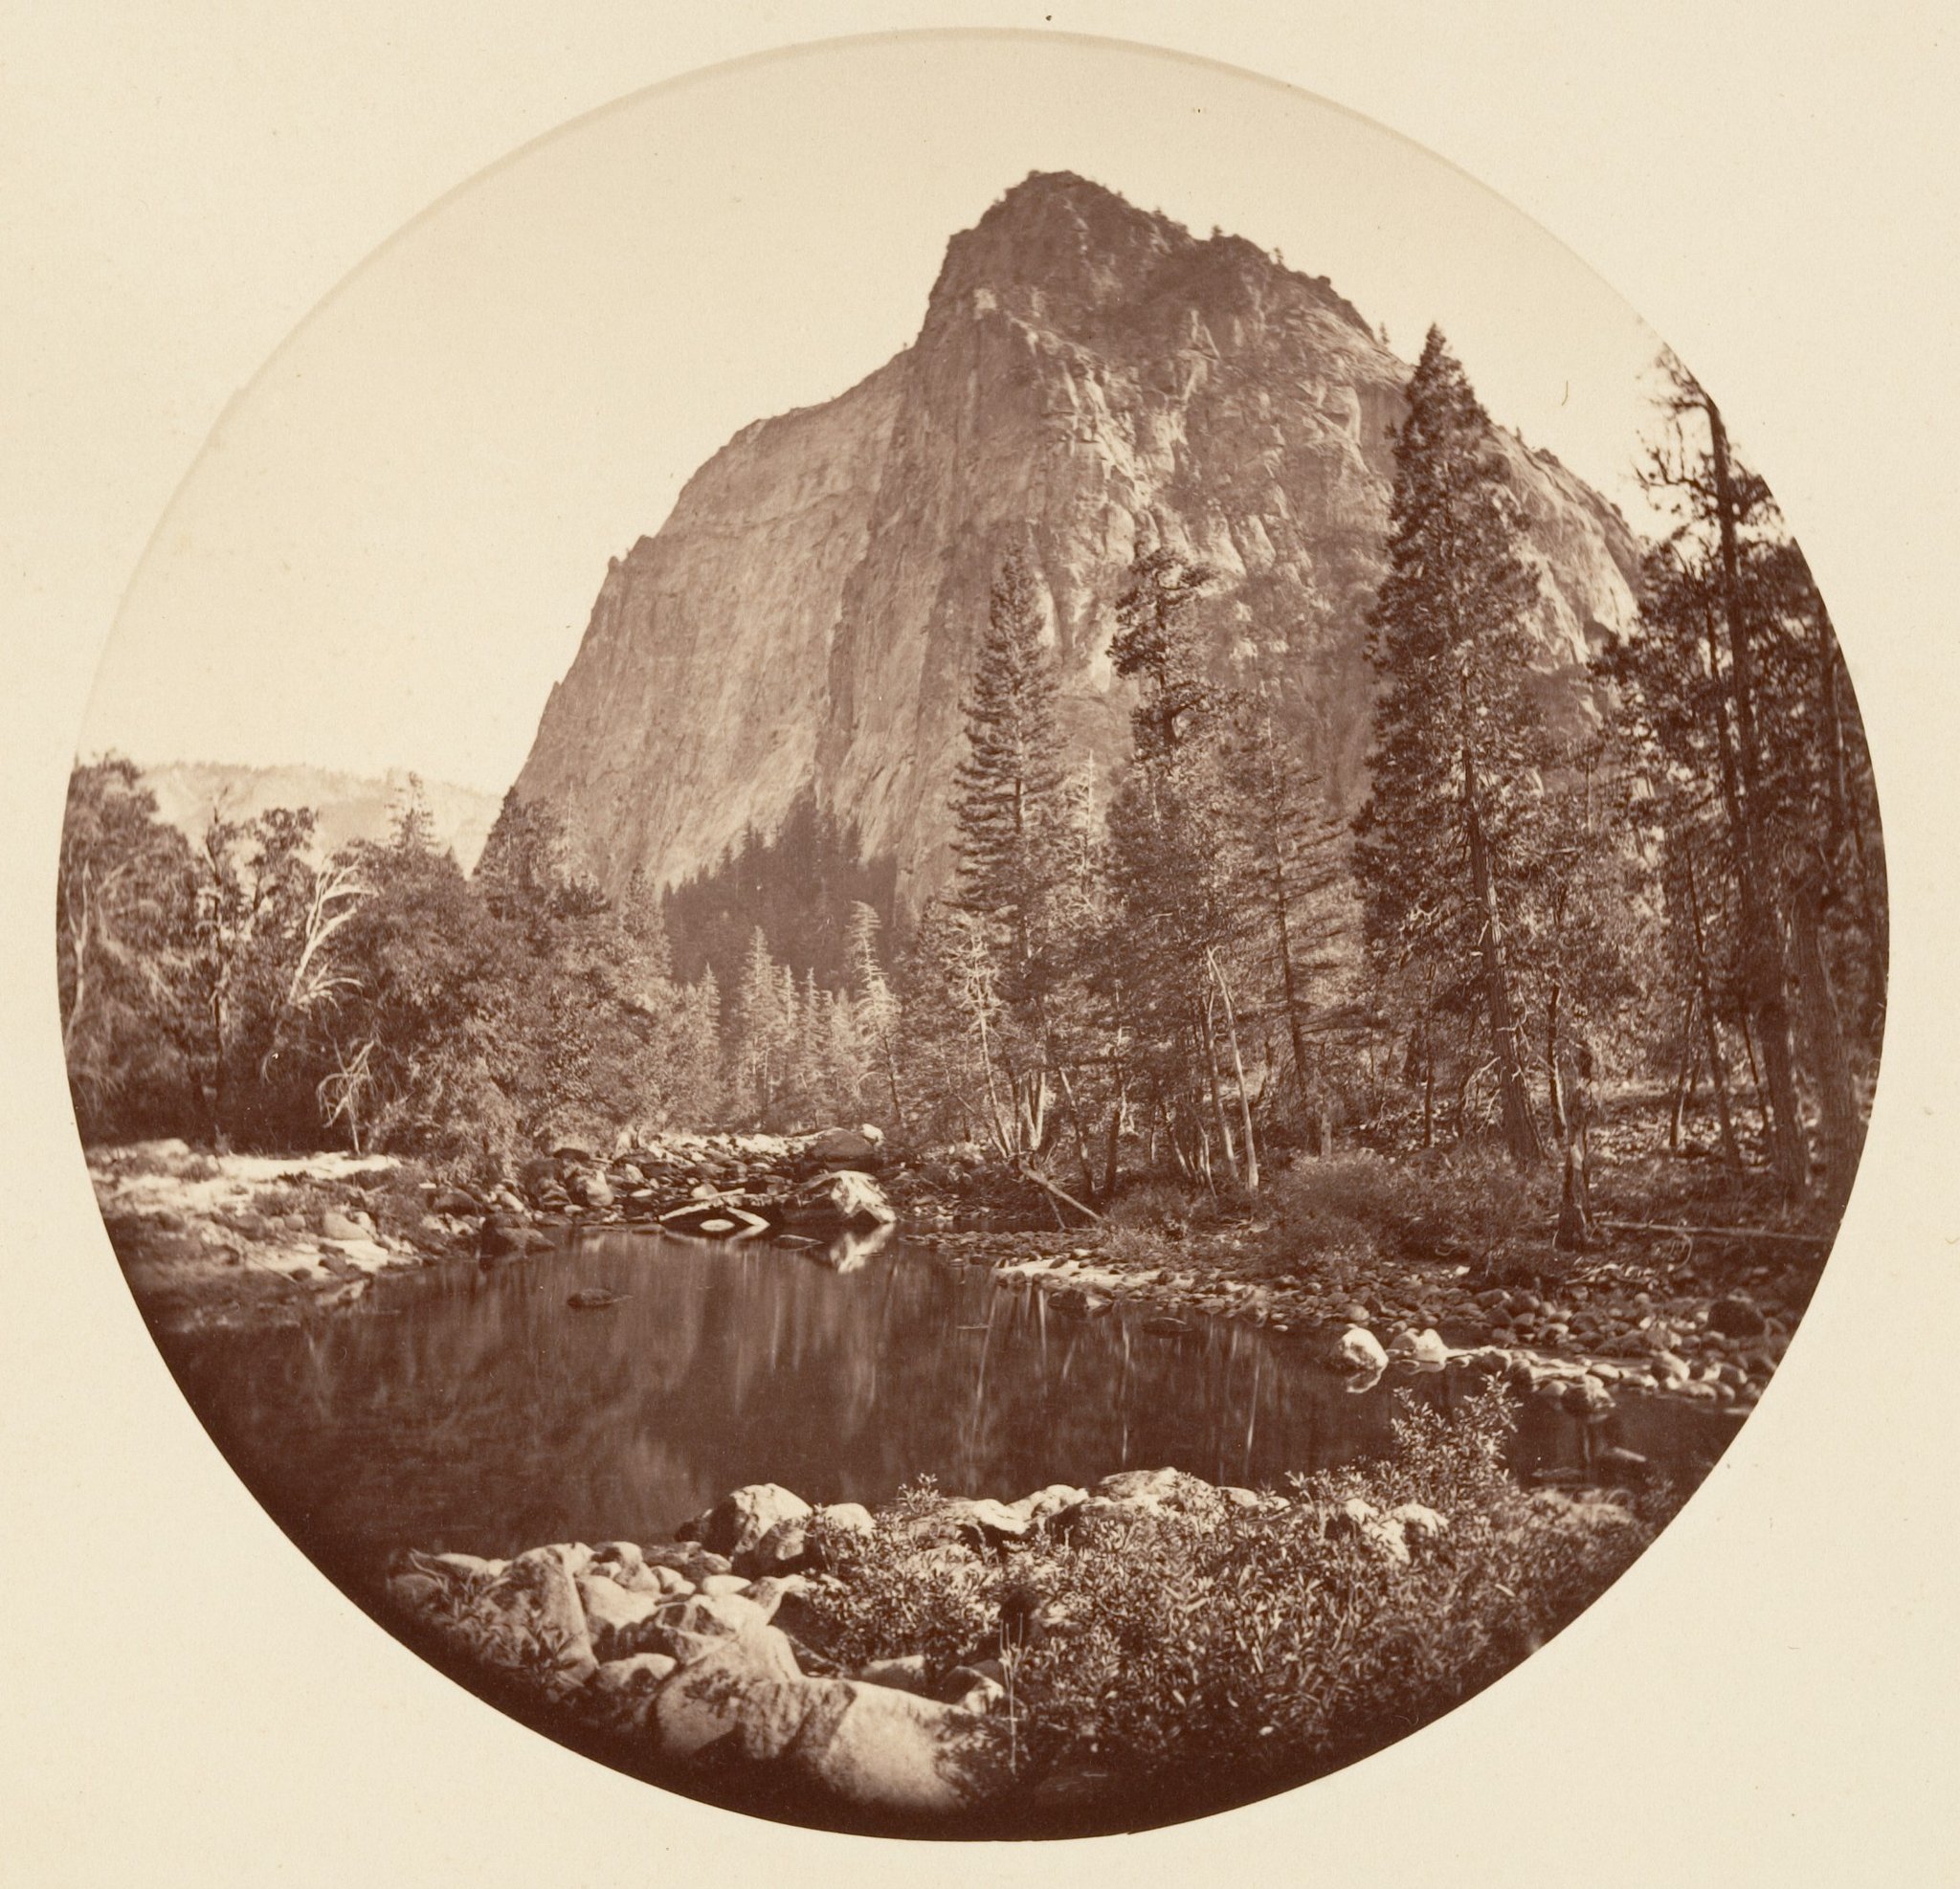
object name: photograph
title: [Yosemite National Park, California]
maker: carleton e. watkins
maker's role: artist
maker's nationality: american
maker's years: 1829-1916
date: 1878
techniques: albumen silver print, glass negative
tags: mountains,landscapes